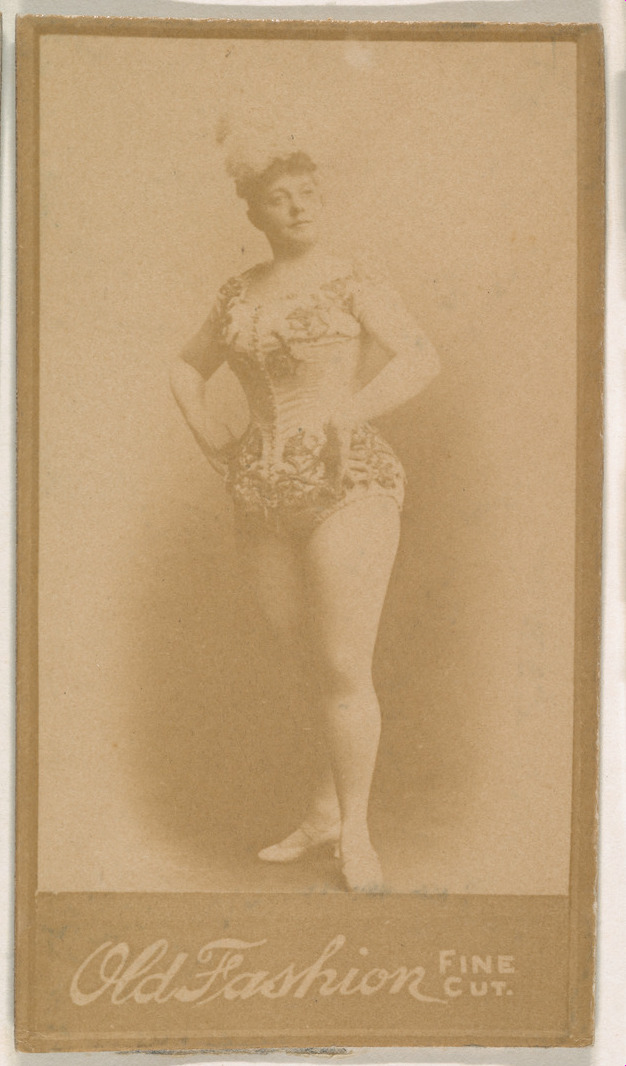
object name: photograph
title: Actress wearing plumed hat, from the Actresses series (N664) promoting Old Fashion Fine Cut Tobacco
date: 1888-1890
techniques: albumen silver print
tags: portraits,women,actresses